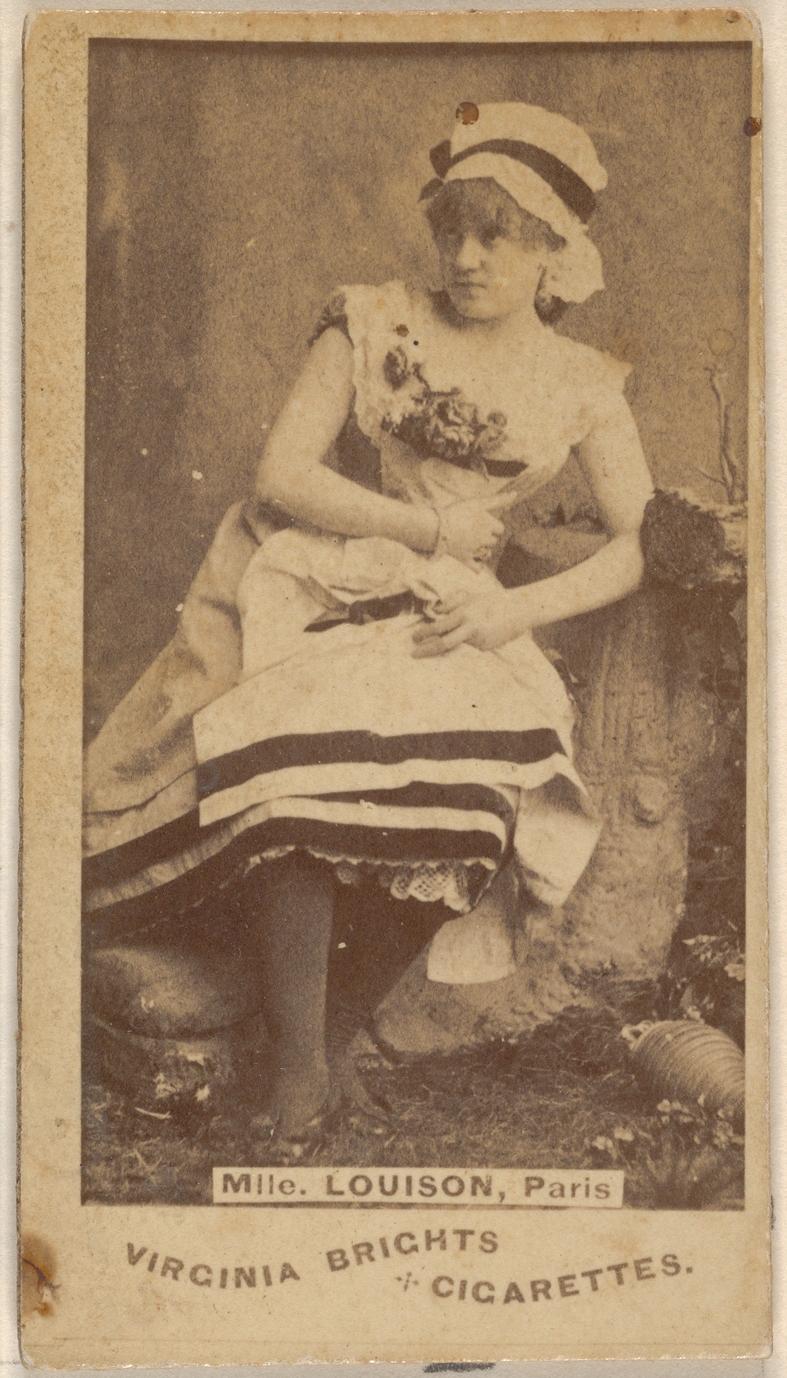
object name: photograph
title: Mlle. Louison, Paris, from the Actors and Actresses series (N45, Type 1) for Virginia Brights Cigarettes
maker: allen & ginter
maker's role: publisher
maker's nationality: american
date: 1888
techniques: albumen silver print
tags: portraits,women,actresses